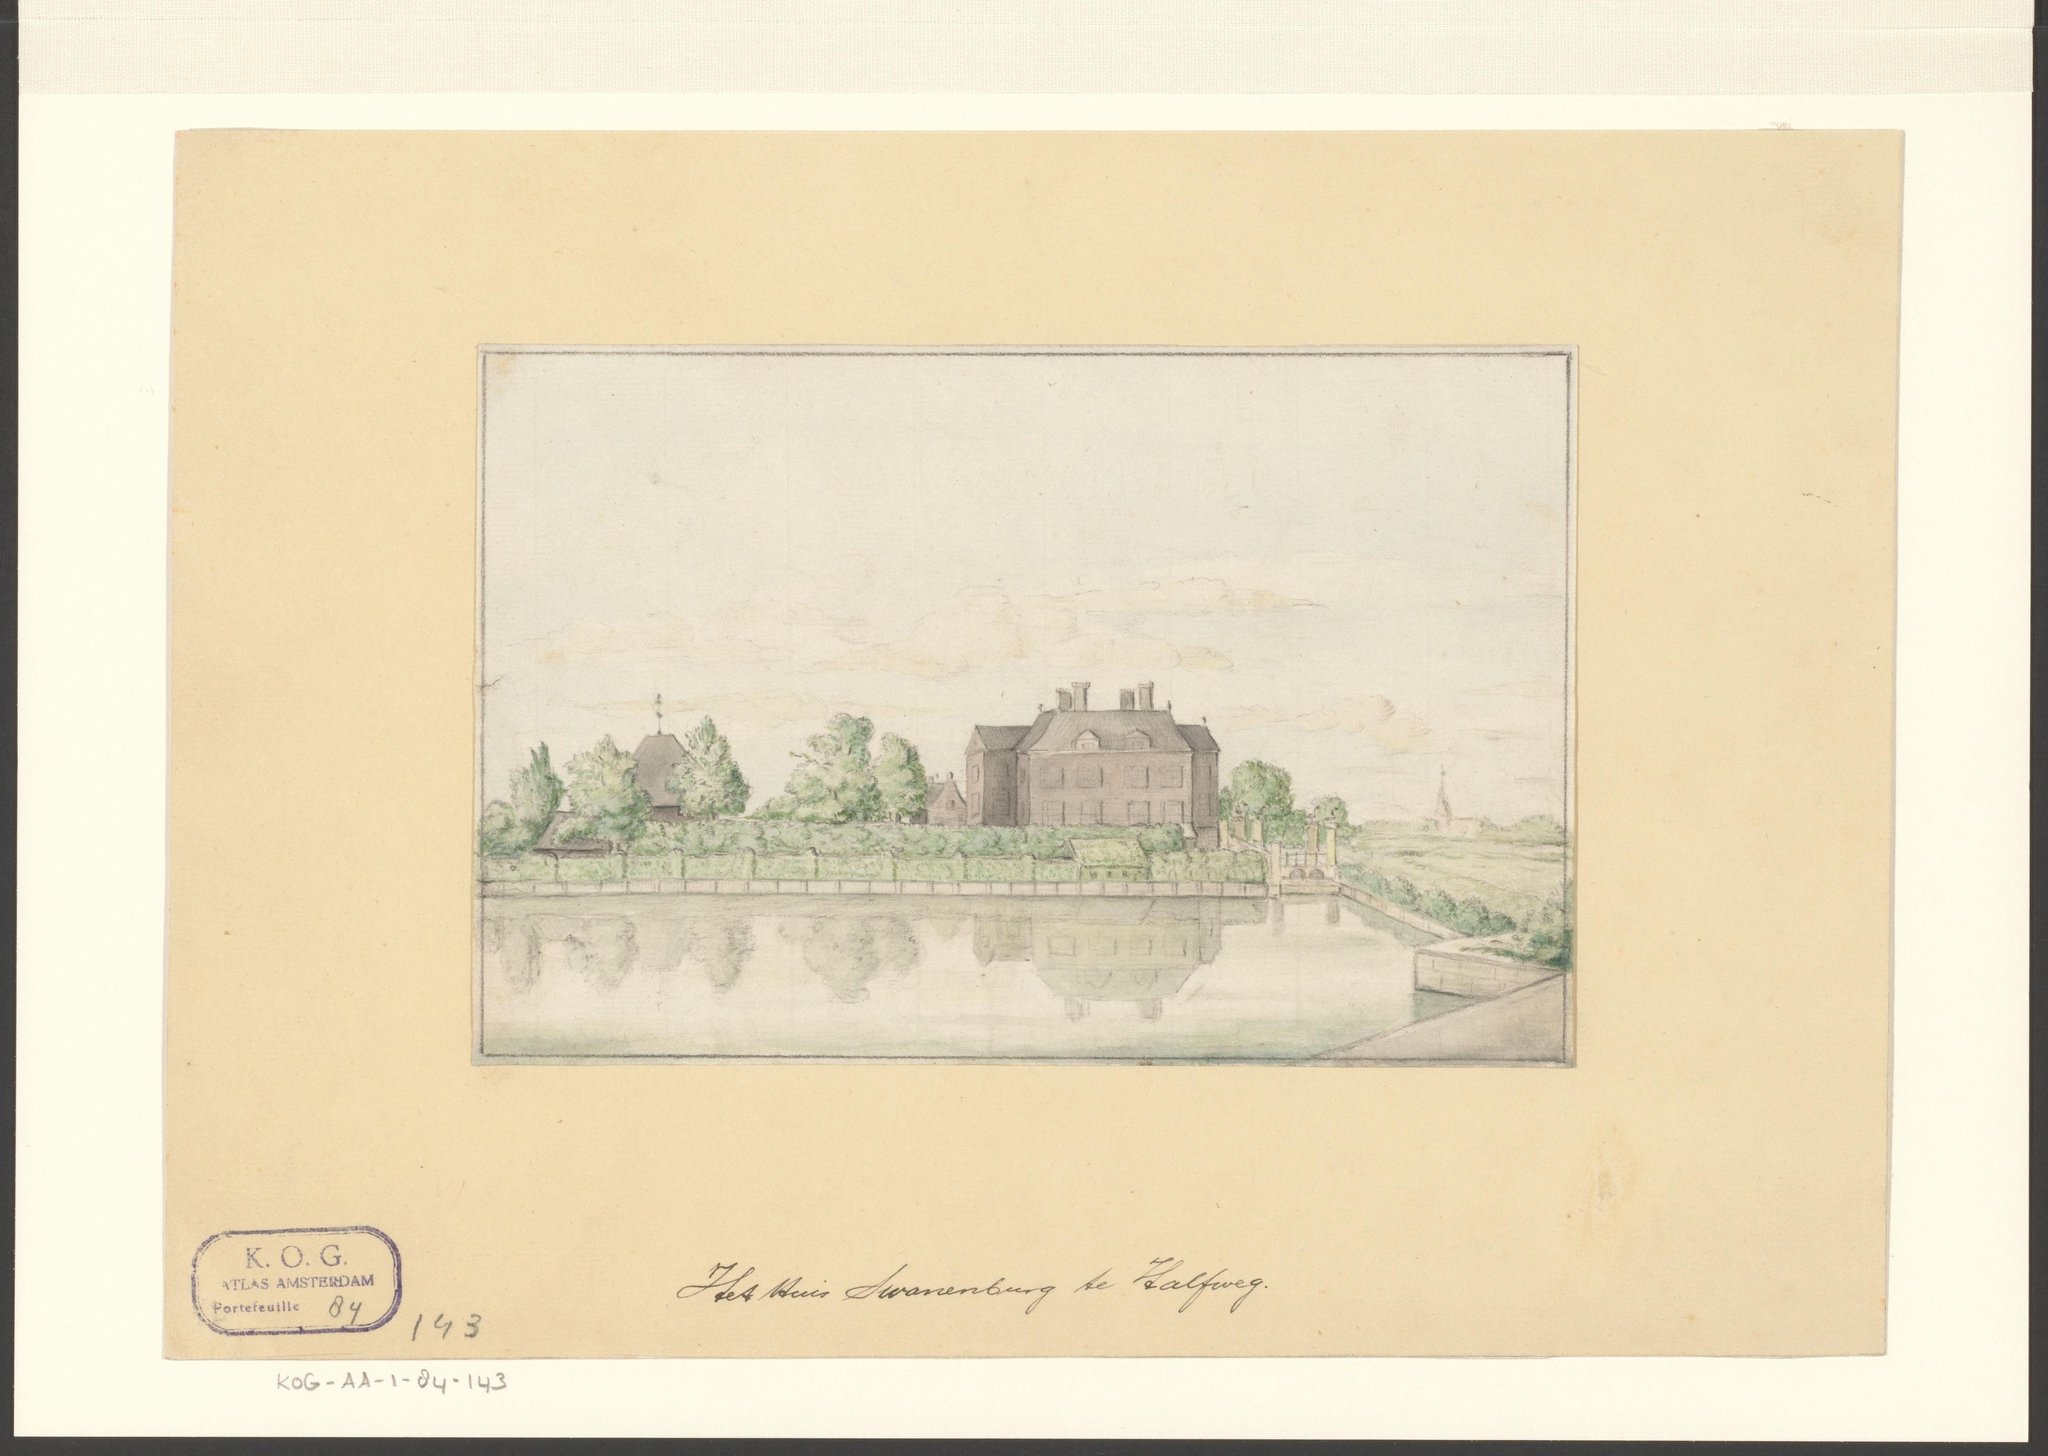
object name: drawing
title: Gezicht op Huis Zwanenburg aan de Halfweg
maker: Anonymous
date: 1750-1850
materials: paper, pencil, watercolor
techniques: brush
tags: city-view in general; 'veduta', rural housing, e.g. country-house, villa, cottage, pond, pool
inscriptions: collector's mark: ‘84 143’ Lugt 1641b, inscription: ‘Het Huis Swanenburg te Halfweg.’, inscription: ‘Het Huis Zwanenburg te Halfweg’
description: Onderwerpsrubriek binnen de Atlas Amsterdam: Halfweg (Houtrijk en Polanen).